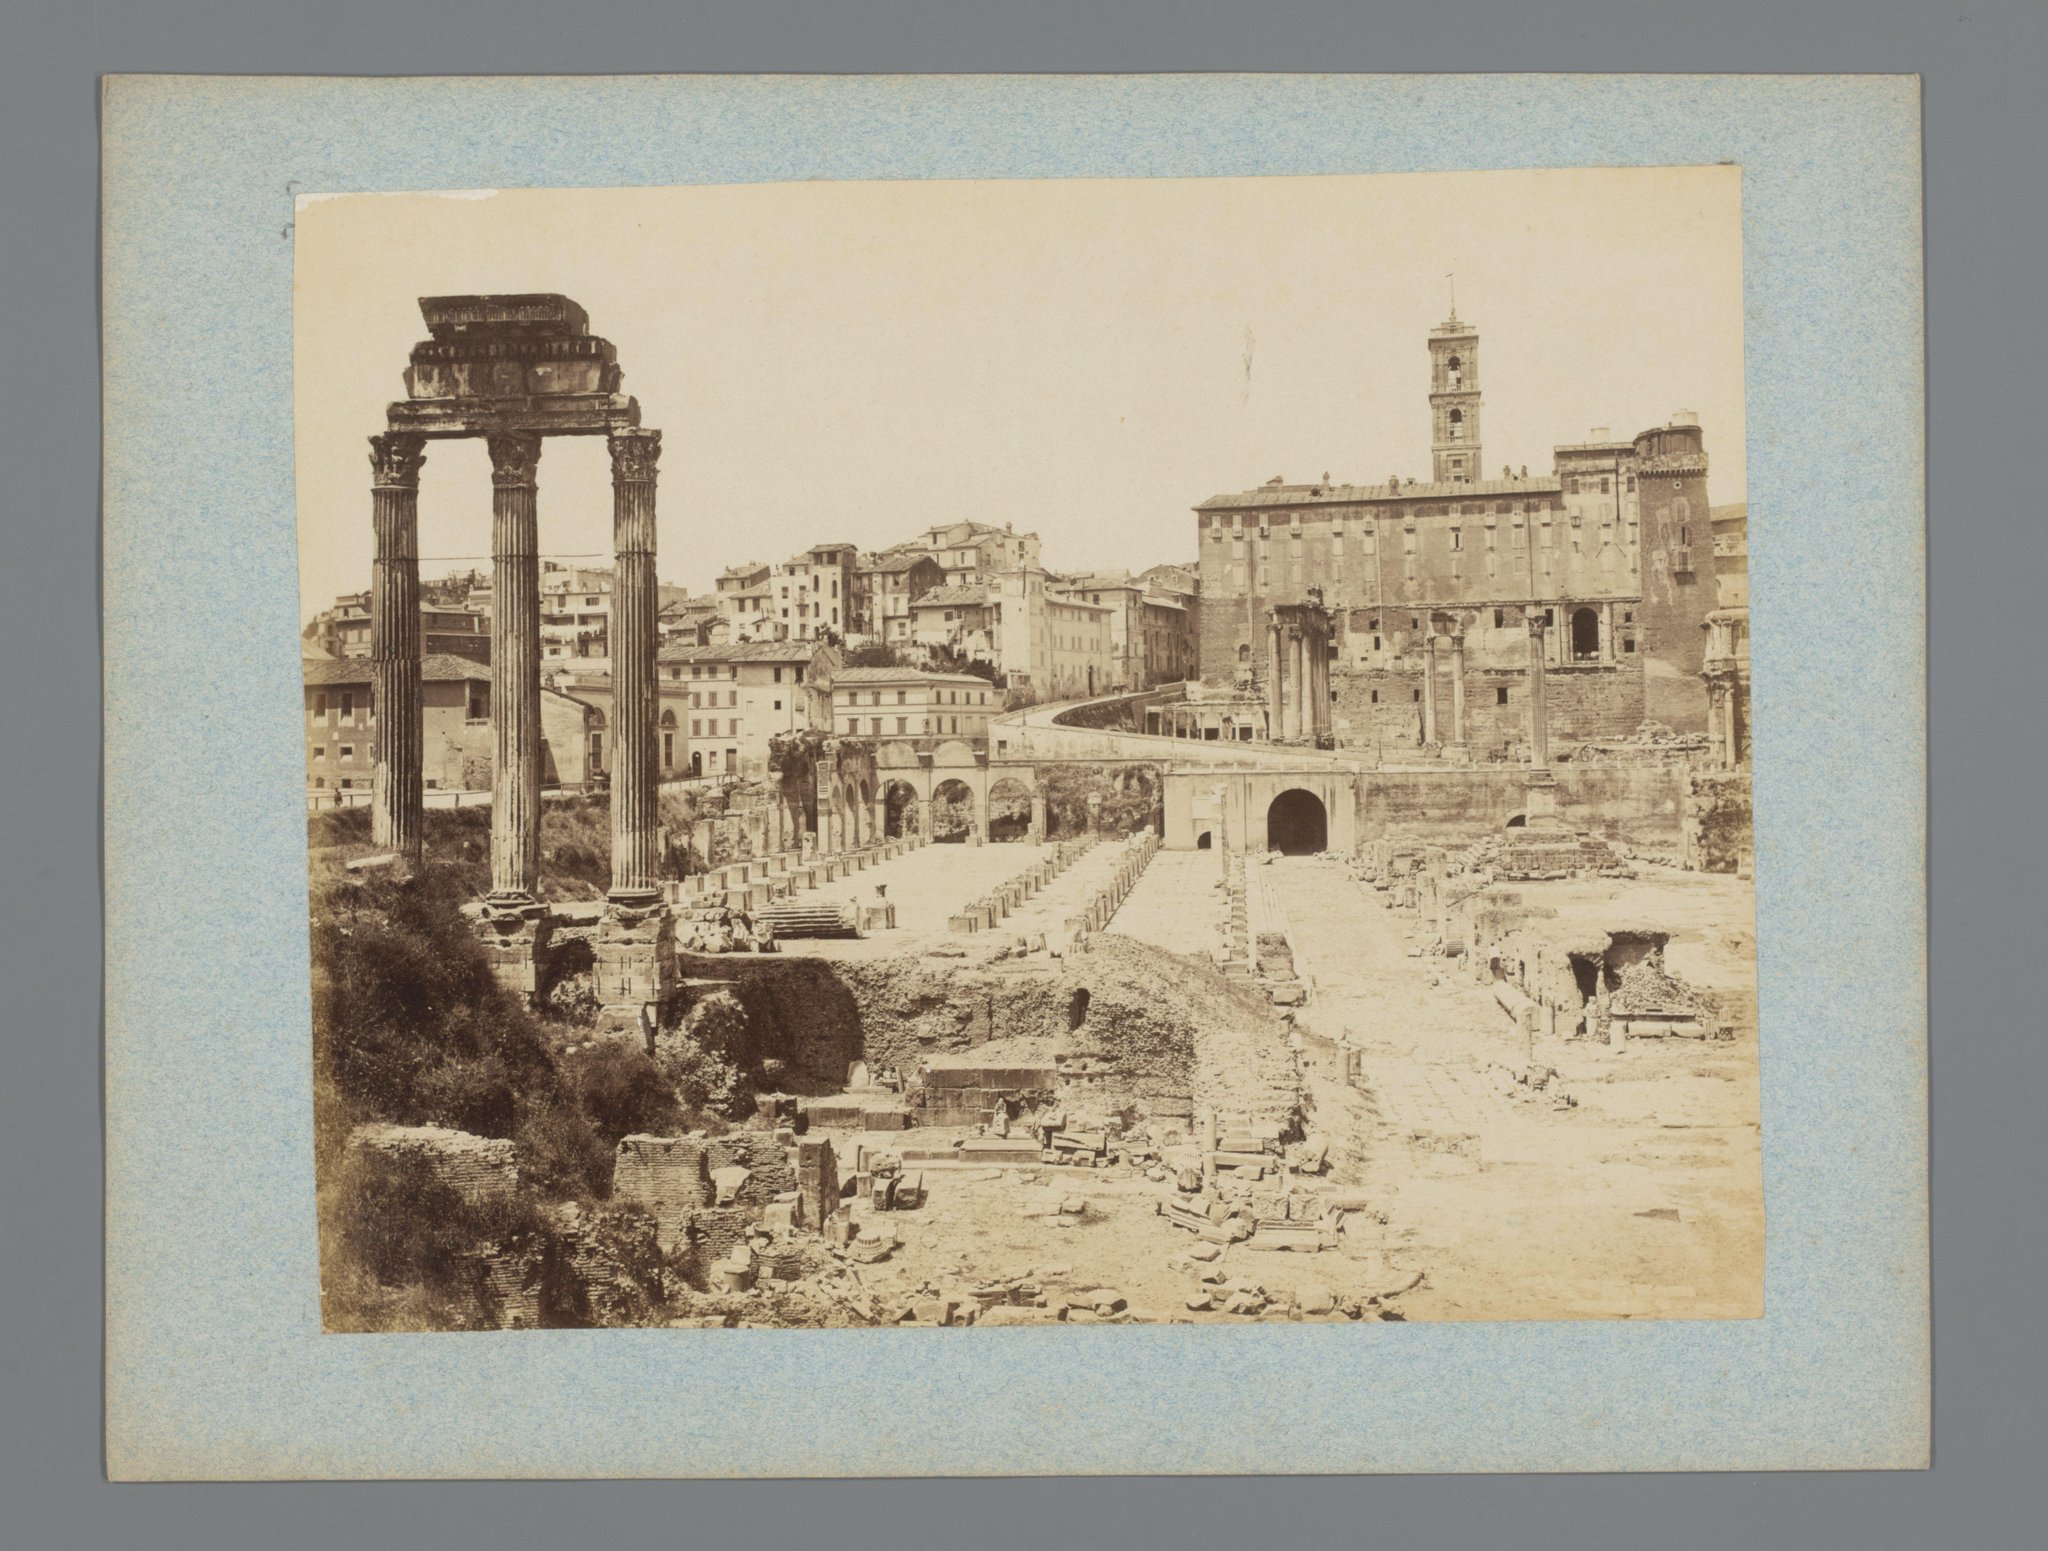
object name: photograph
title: Gezicht op het Forum Romanum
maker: Anonymous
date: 1851-1900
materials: cardboard, paper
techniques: albumen print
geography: forum romanum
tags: ruin of a building ~ architecture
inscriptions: collector's mark: ‘VOSMAER’, inscription: ‘Foro Romano’